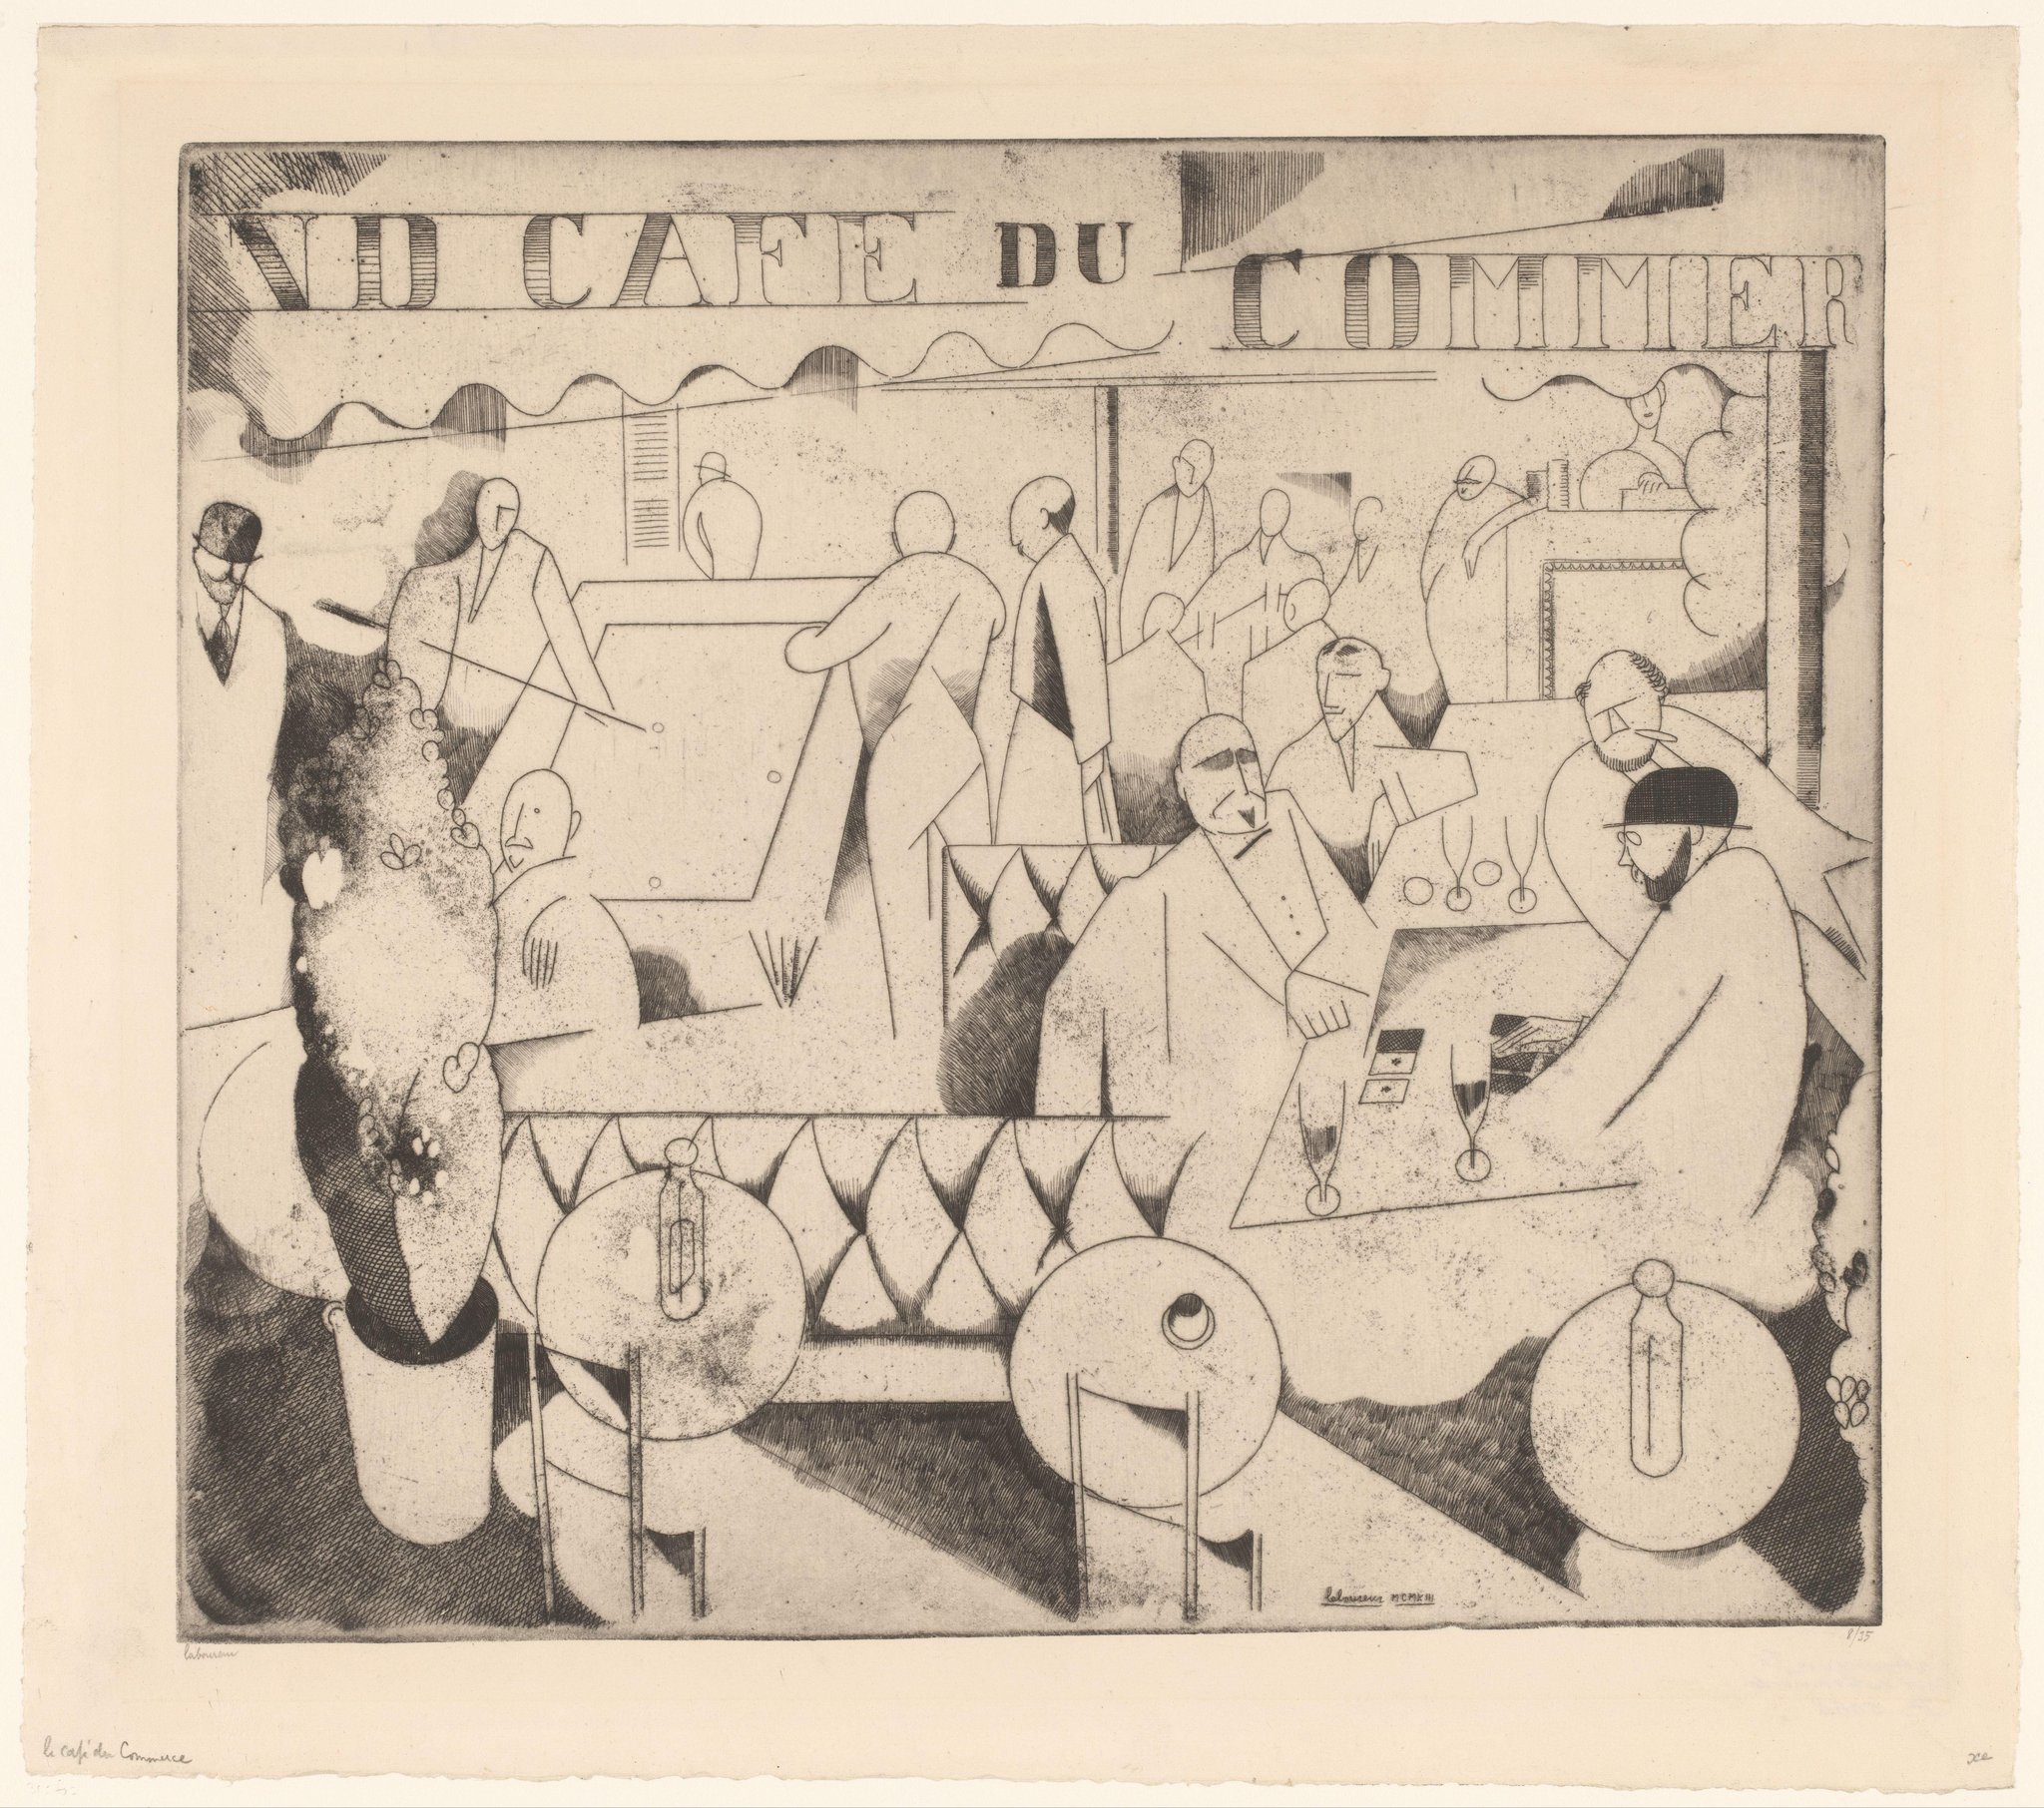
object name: print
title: Le café du commerce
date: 1913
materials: paper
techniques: aquatint, etching, intaglio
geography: france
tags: billiards, inn, coffee-house, public house, etc., playing-cards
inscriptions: check stamp: Lugt 2254, collector's mark: Lugt 2228, inscription: ‘xe’